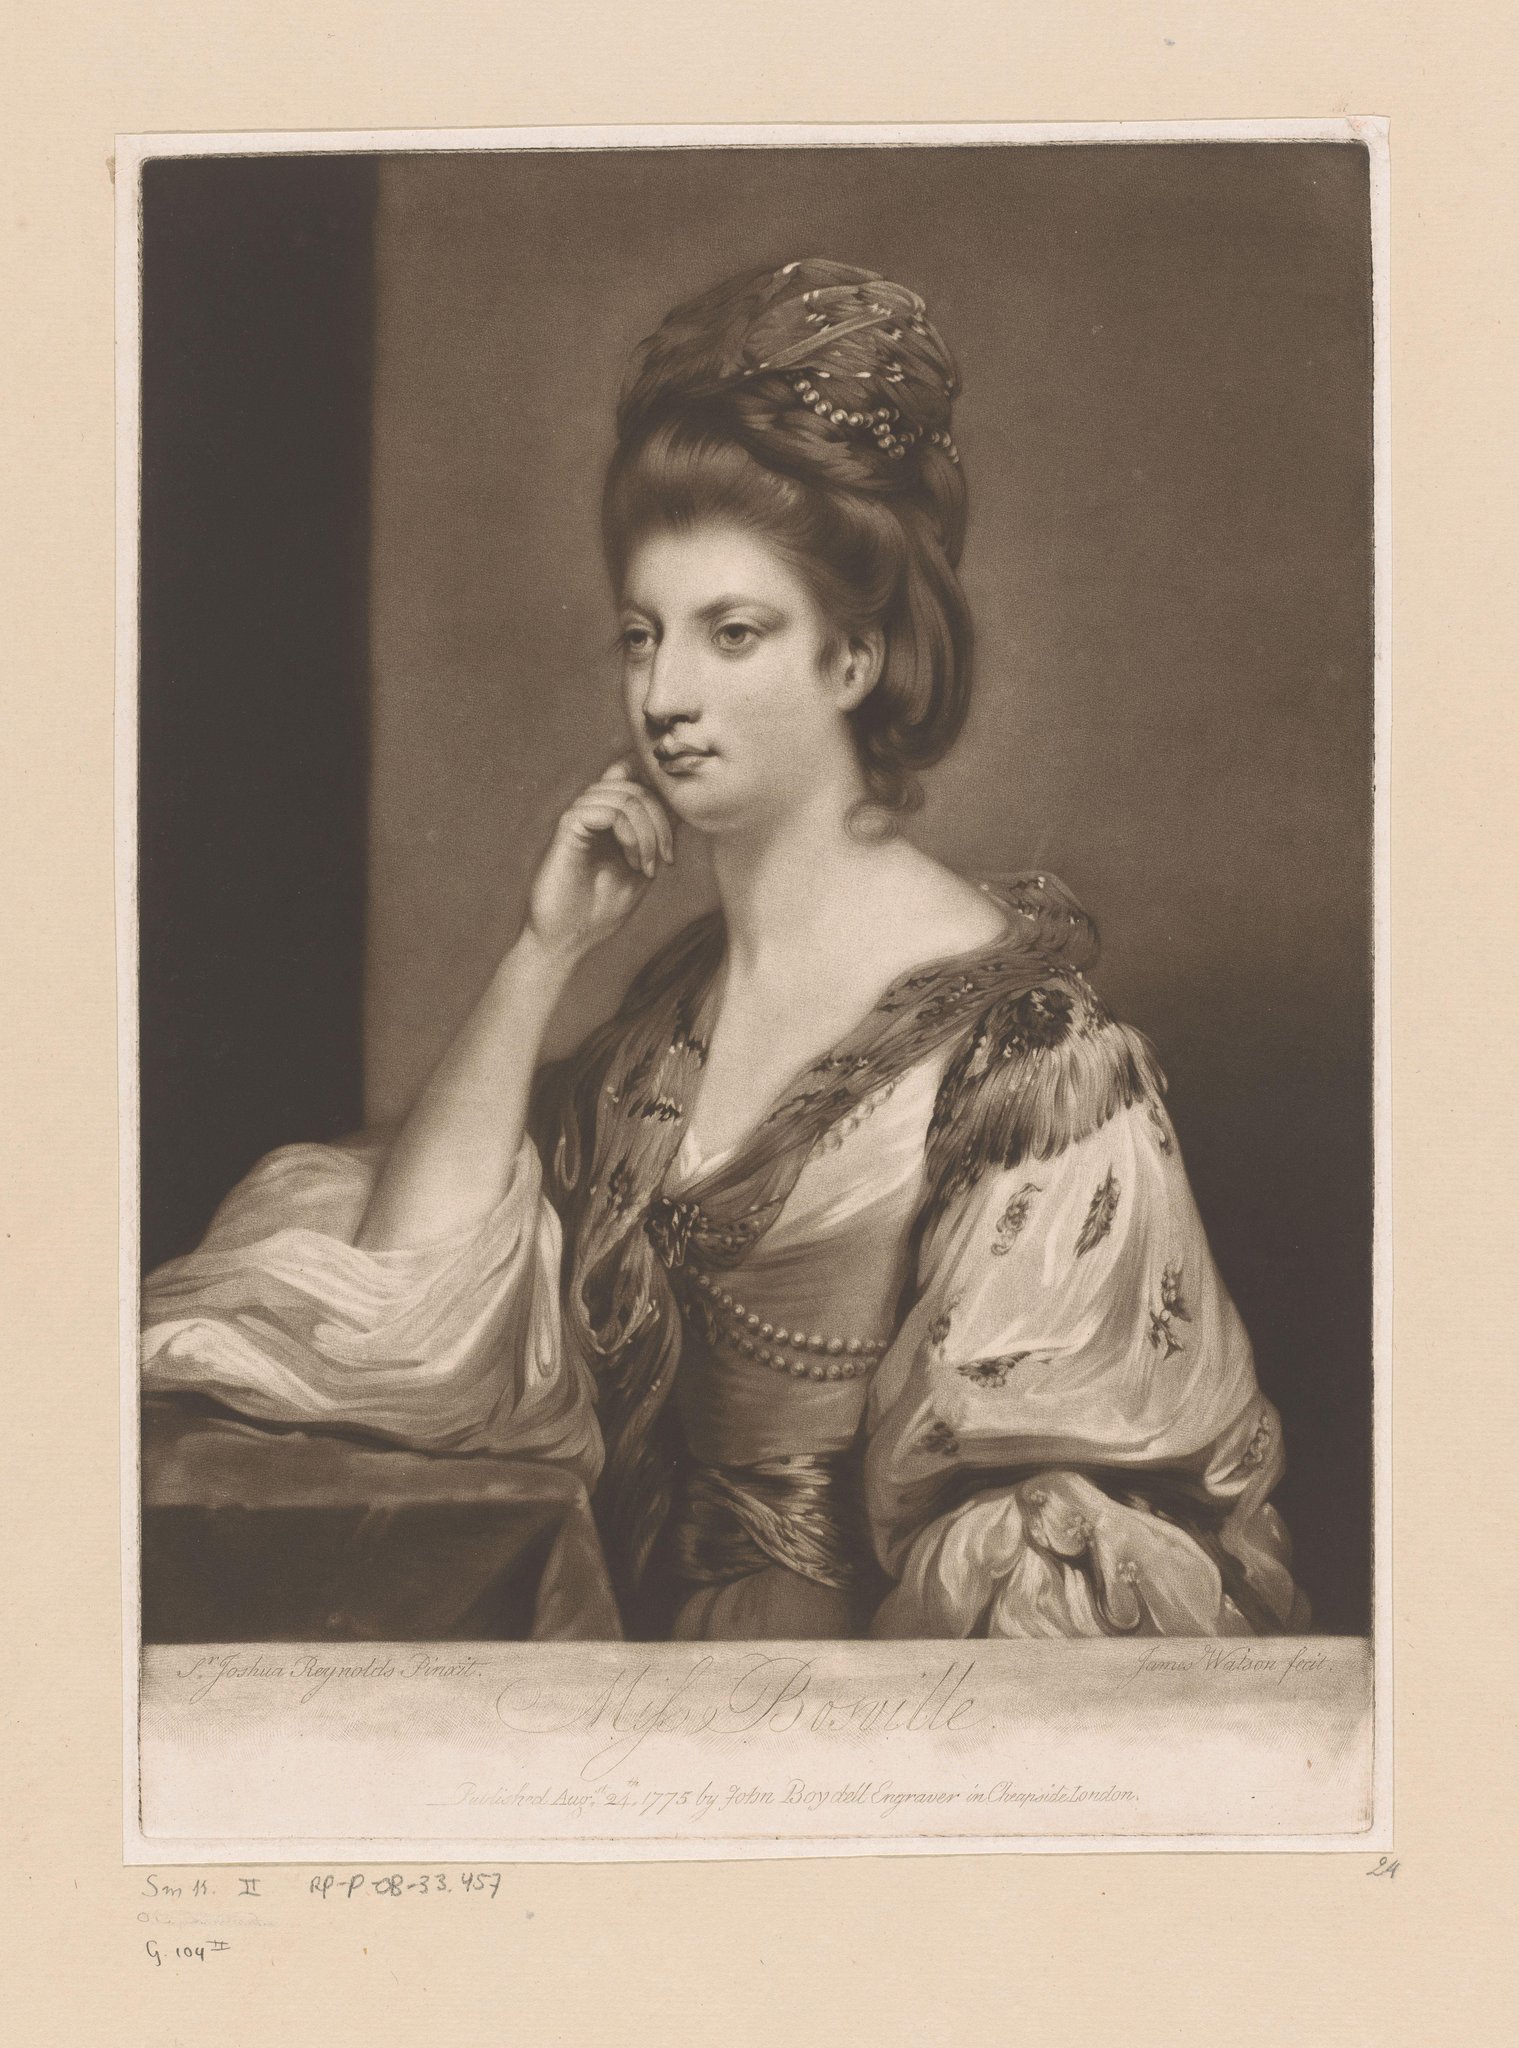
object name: print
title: Portret van Julia Bosville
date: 1708-1775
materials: paper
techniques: mezzotint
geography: london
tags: historical persons - bb - woman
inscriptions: collector's mark: Lugt 240